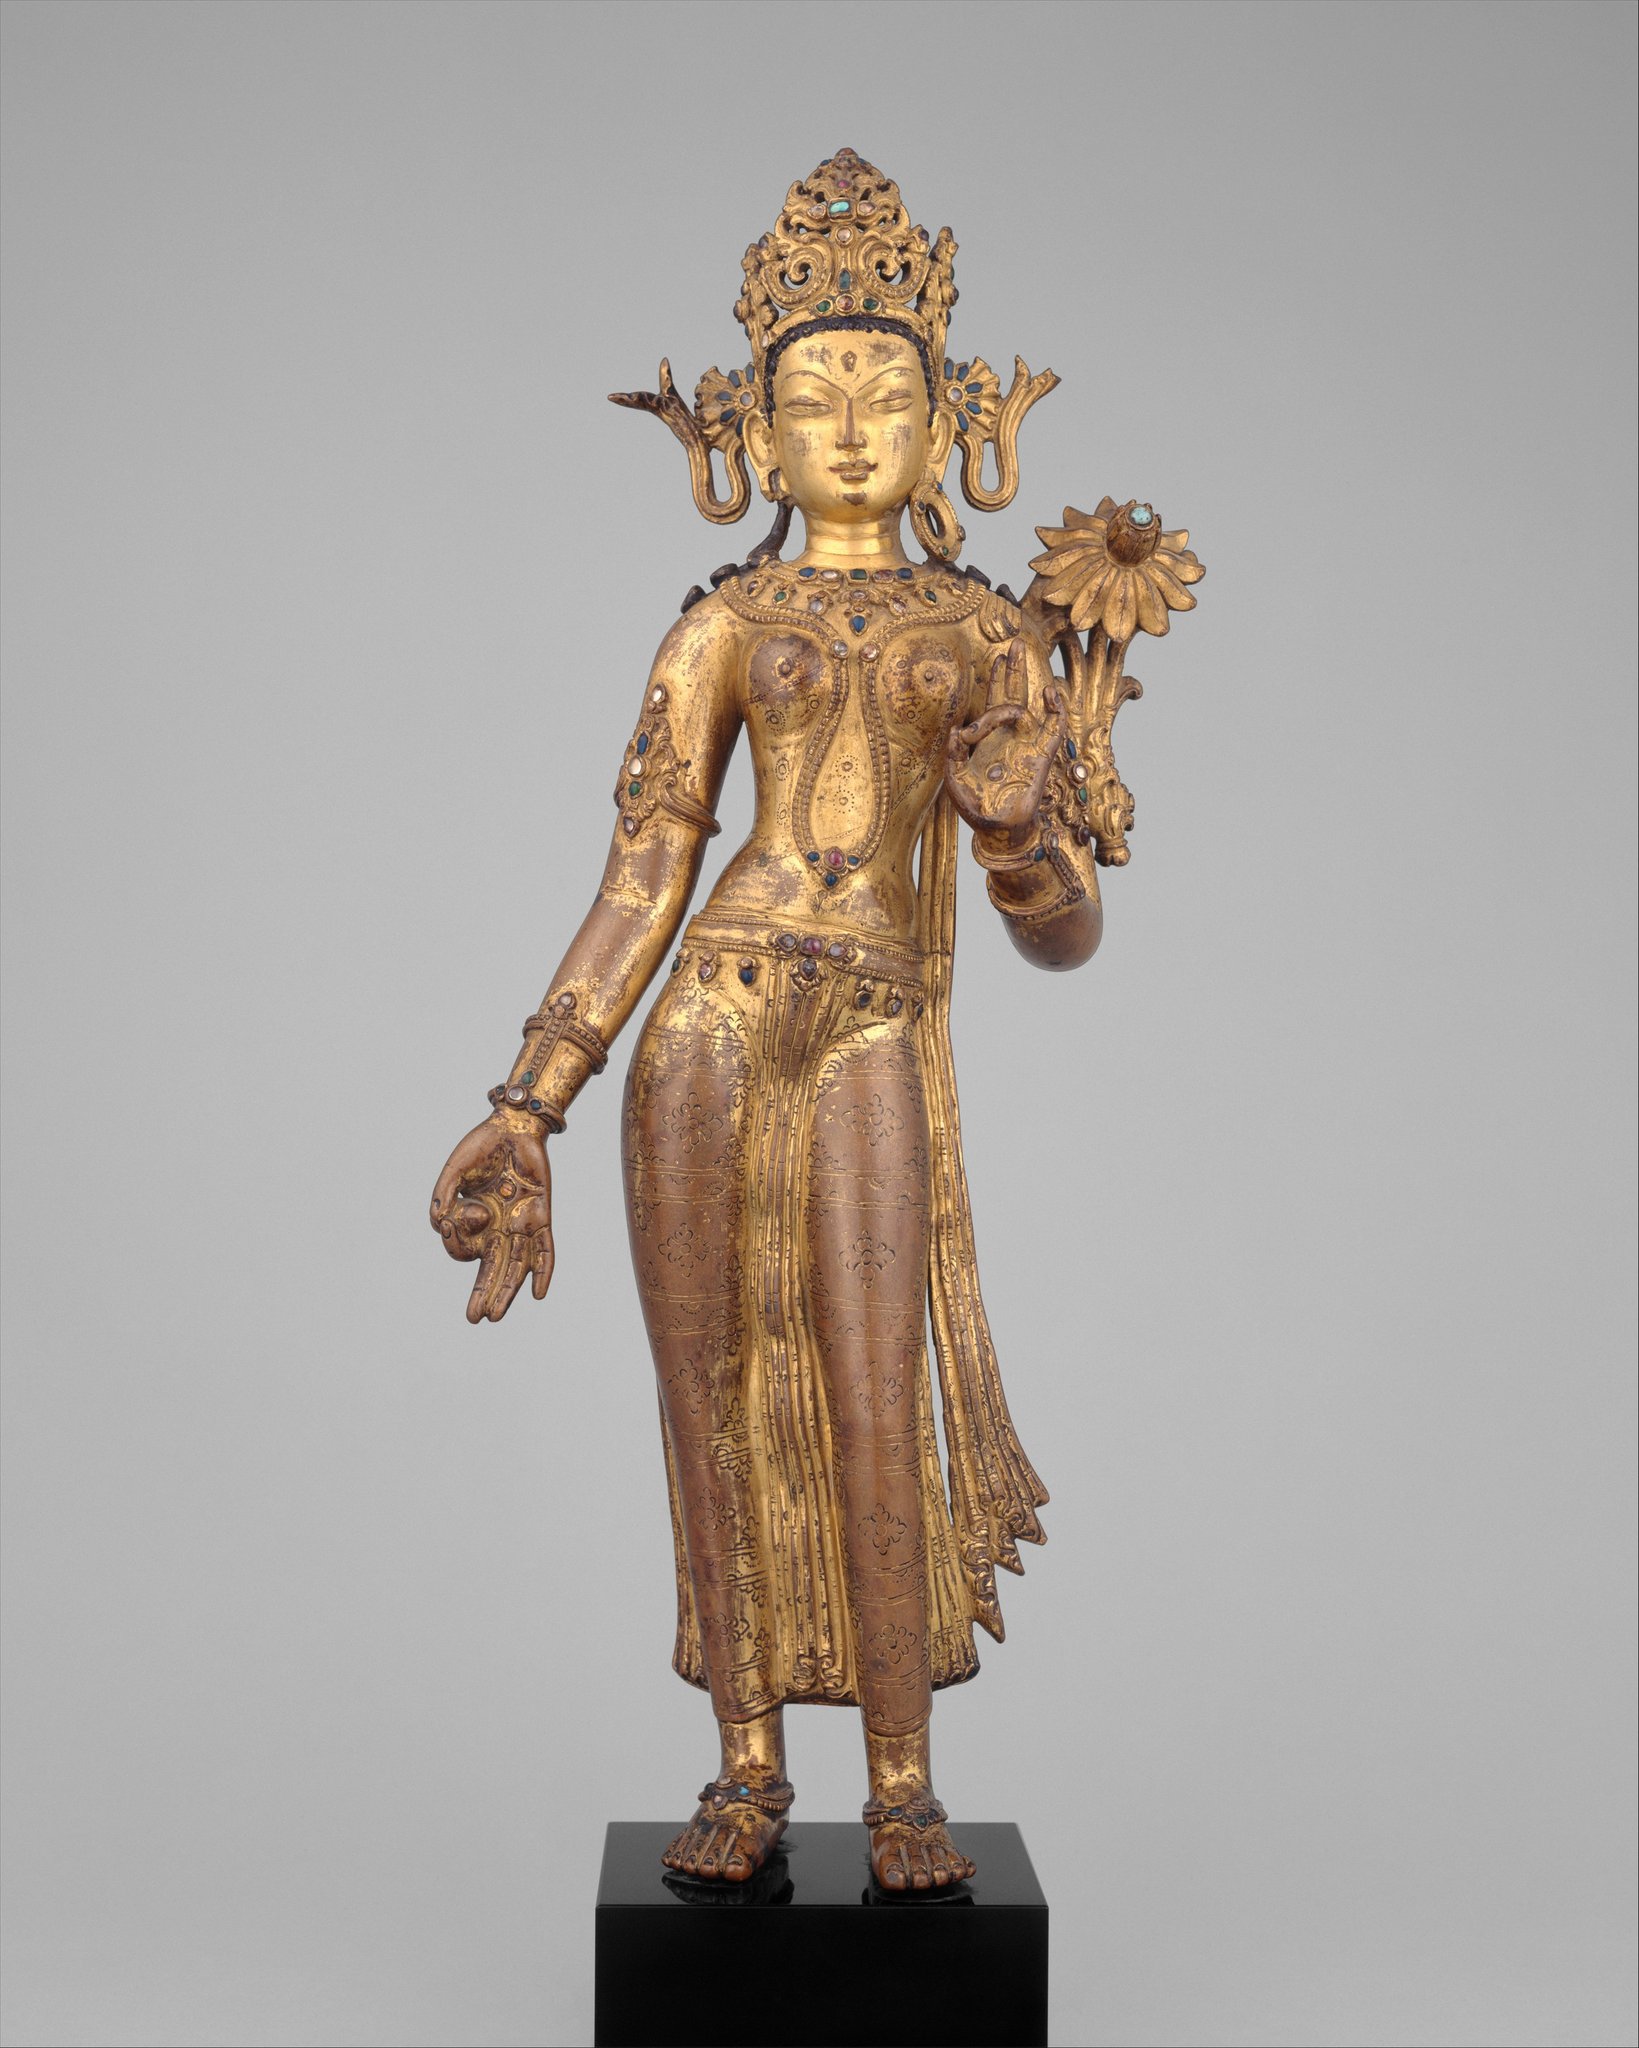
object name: figure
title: Tara, the Buddhist Savior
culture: nepali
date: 1301-1400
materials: copper alloy, gilt, stone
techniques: inlay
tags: lotuses,buddhism,deities